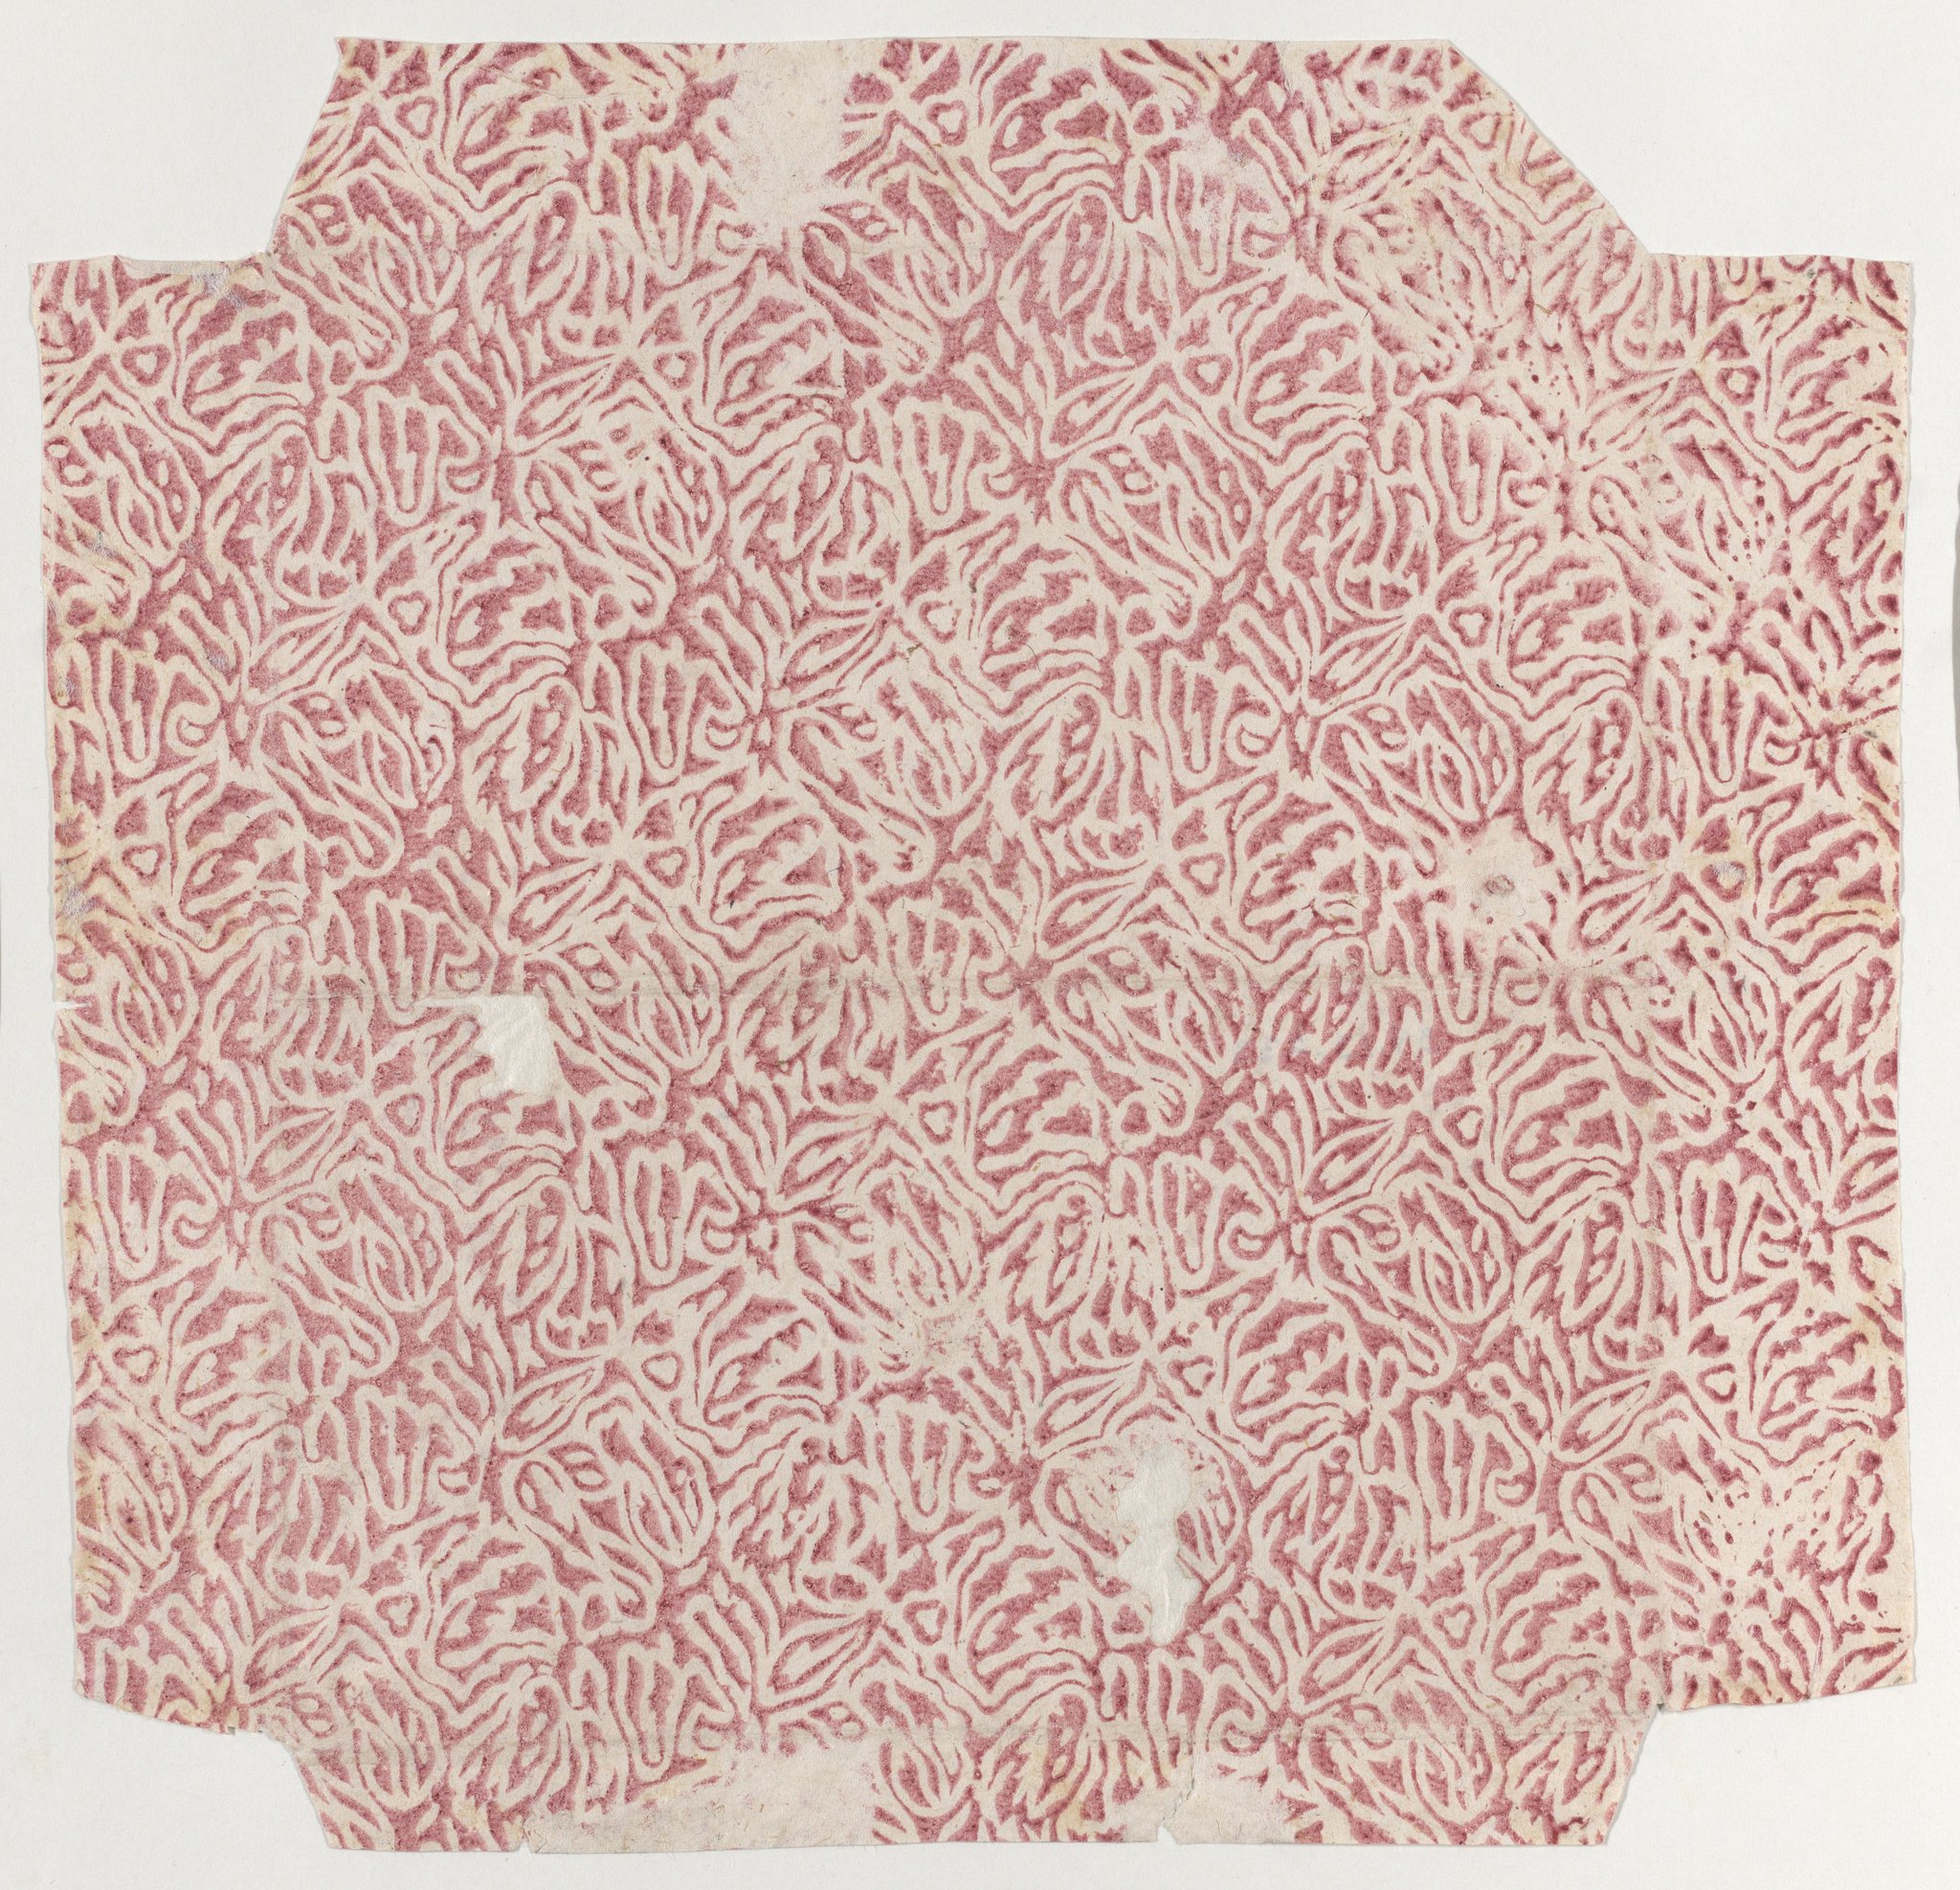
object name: print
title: Sheet with red abstract pattern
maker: Anonymous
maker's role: artist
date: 1701-1800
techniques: relief print